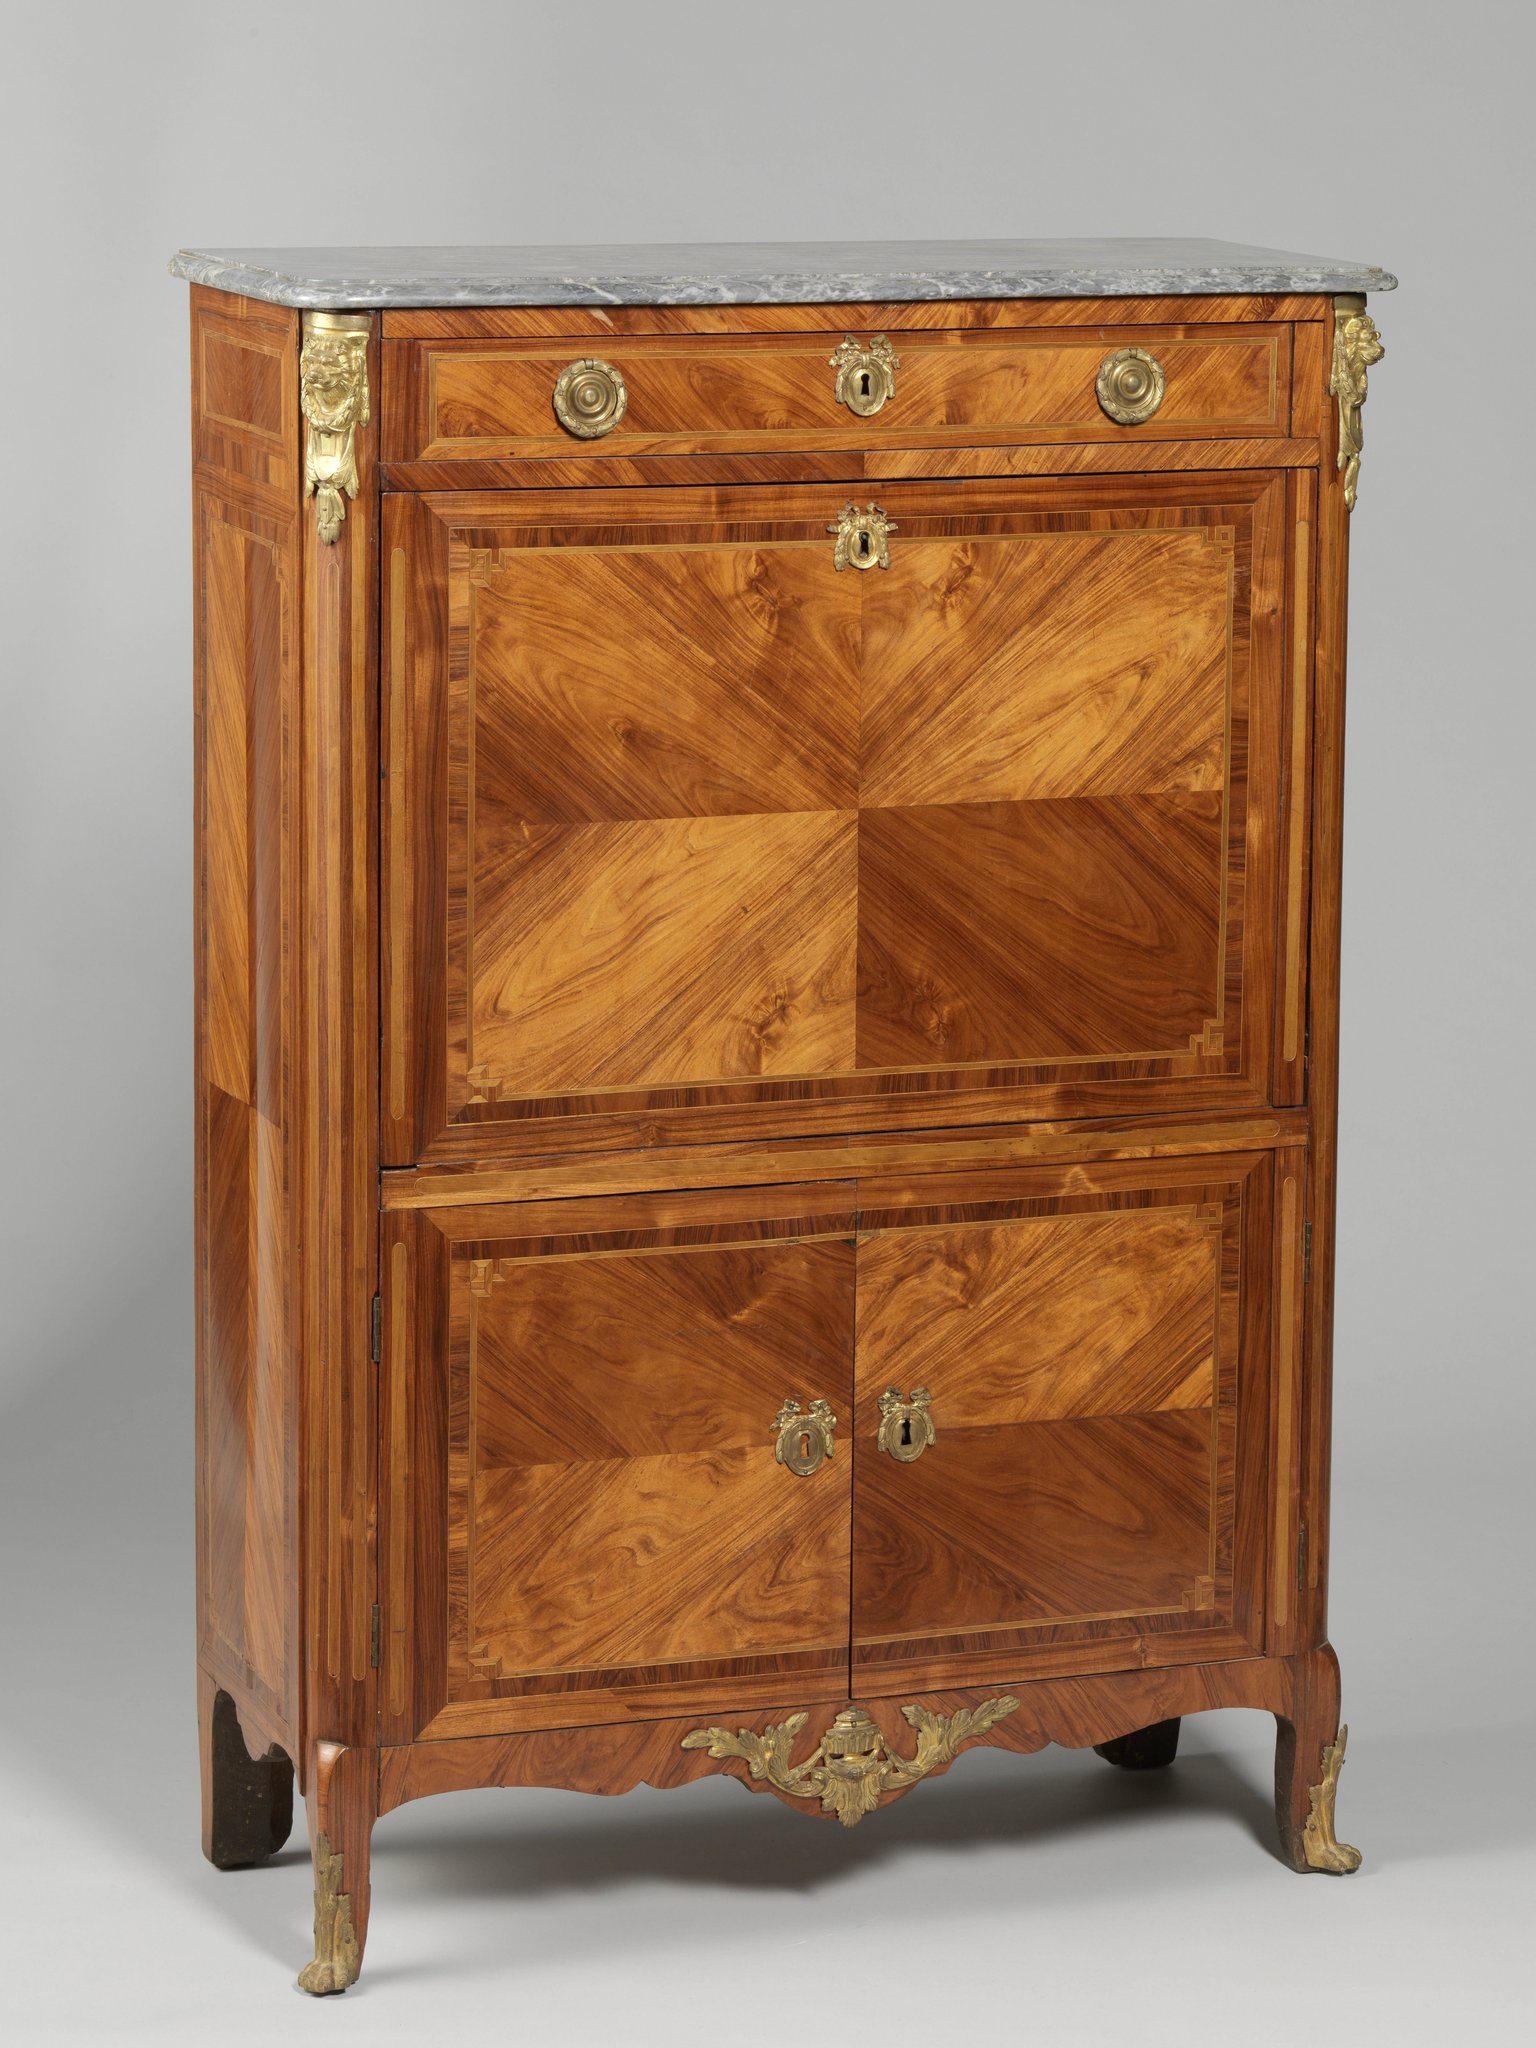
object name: desk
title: Secretaire belijmd met roze- en esdoornhout en met blauw-grijs geaderd blad van marmer. Twee onderdeuren, een neerklapbaar blad en een lade. Beslag van verguld koper of brons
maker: pierre roussel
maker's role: furniture worker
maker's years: 1723-1782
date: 1770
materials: bronze, copper, wood, marble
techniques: gilding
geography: france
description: Eikenhouten secretaire belijmd met roze- en esdoornhout. De ornamenten zijn van verguld koper of brons. De overhoeks geplaatste voorpoten dragen leeuweklauwen met bladwerk, de hoekstijlen bovenaan een leeuwekop met guirlande en de dubbel accoladevormige onderdorpel een vaasvorm met guirlande en bladwerk. De twee onderdeuren, het neerklapbare blad, de lade erboven en de zijkanten tonen rechthoekige velden binnen een band met gevlochten hoeken. Blauw-grijs geaderd marmeren blad; versierde sleutelplaten.